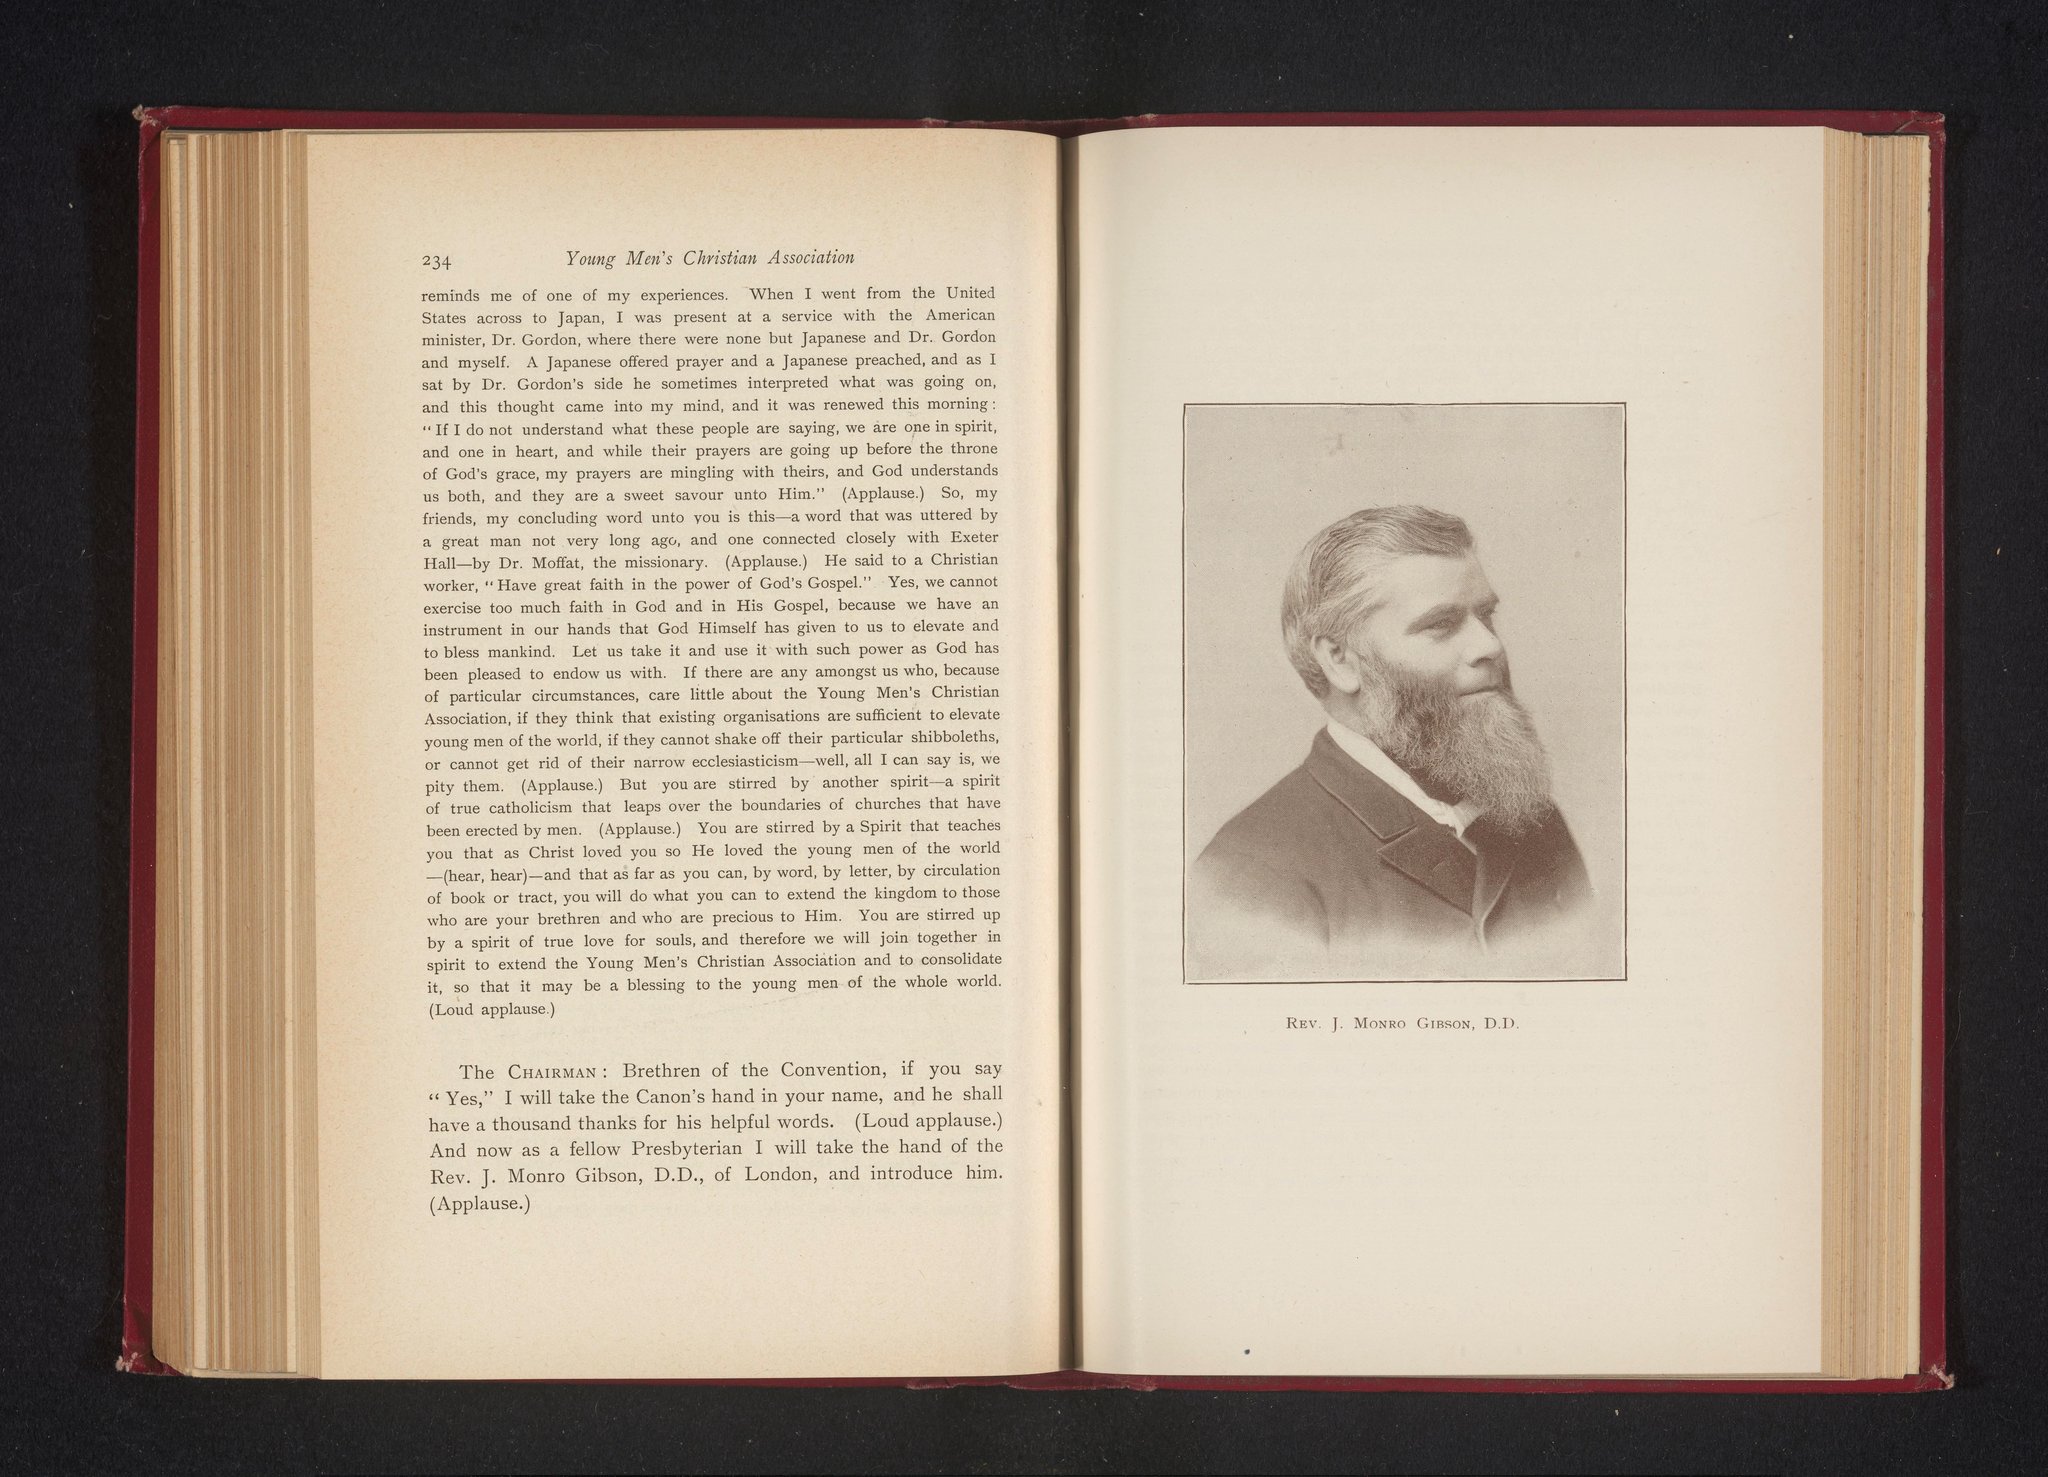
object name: page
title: Portret van John Monro Gibson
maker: Anonymous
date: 1890-1895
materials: paper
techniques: autotype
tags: historical persons